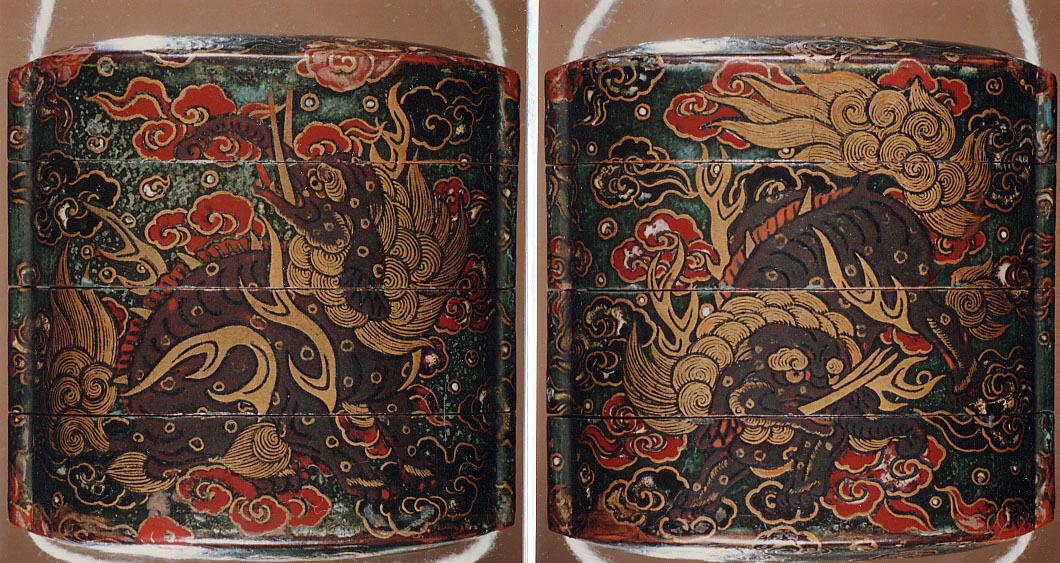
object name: inrō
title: Case (Inrō) with Design of Baku (Mythical Animals) among Ruyi-Shaped Clouds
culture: japanese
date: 1701-1800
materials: gold, lacquer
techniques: fundame, hiramakie, roiro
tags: mythical creatures,clouds